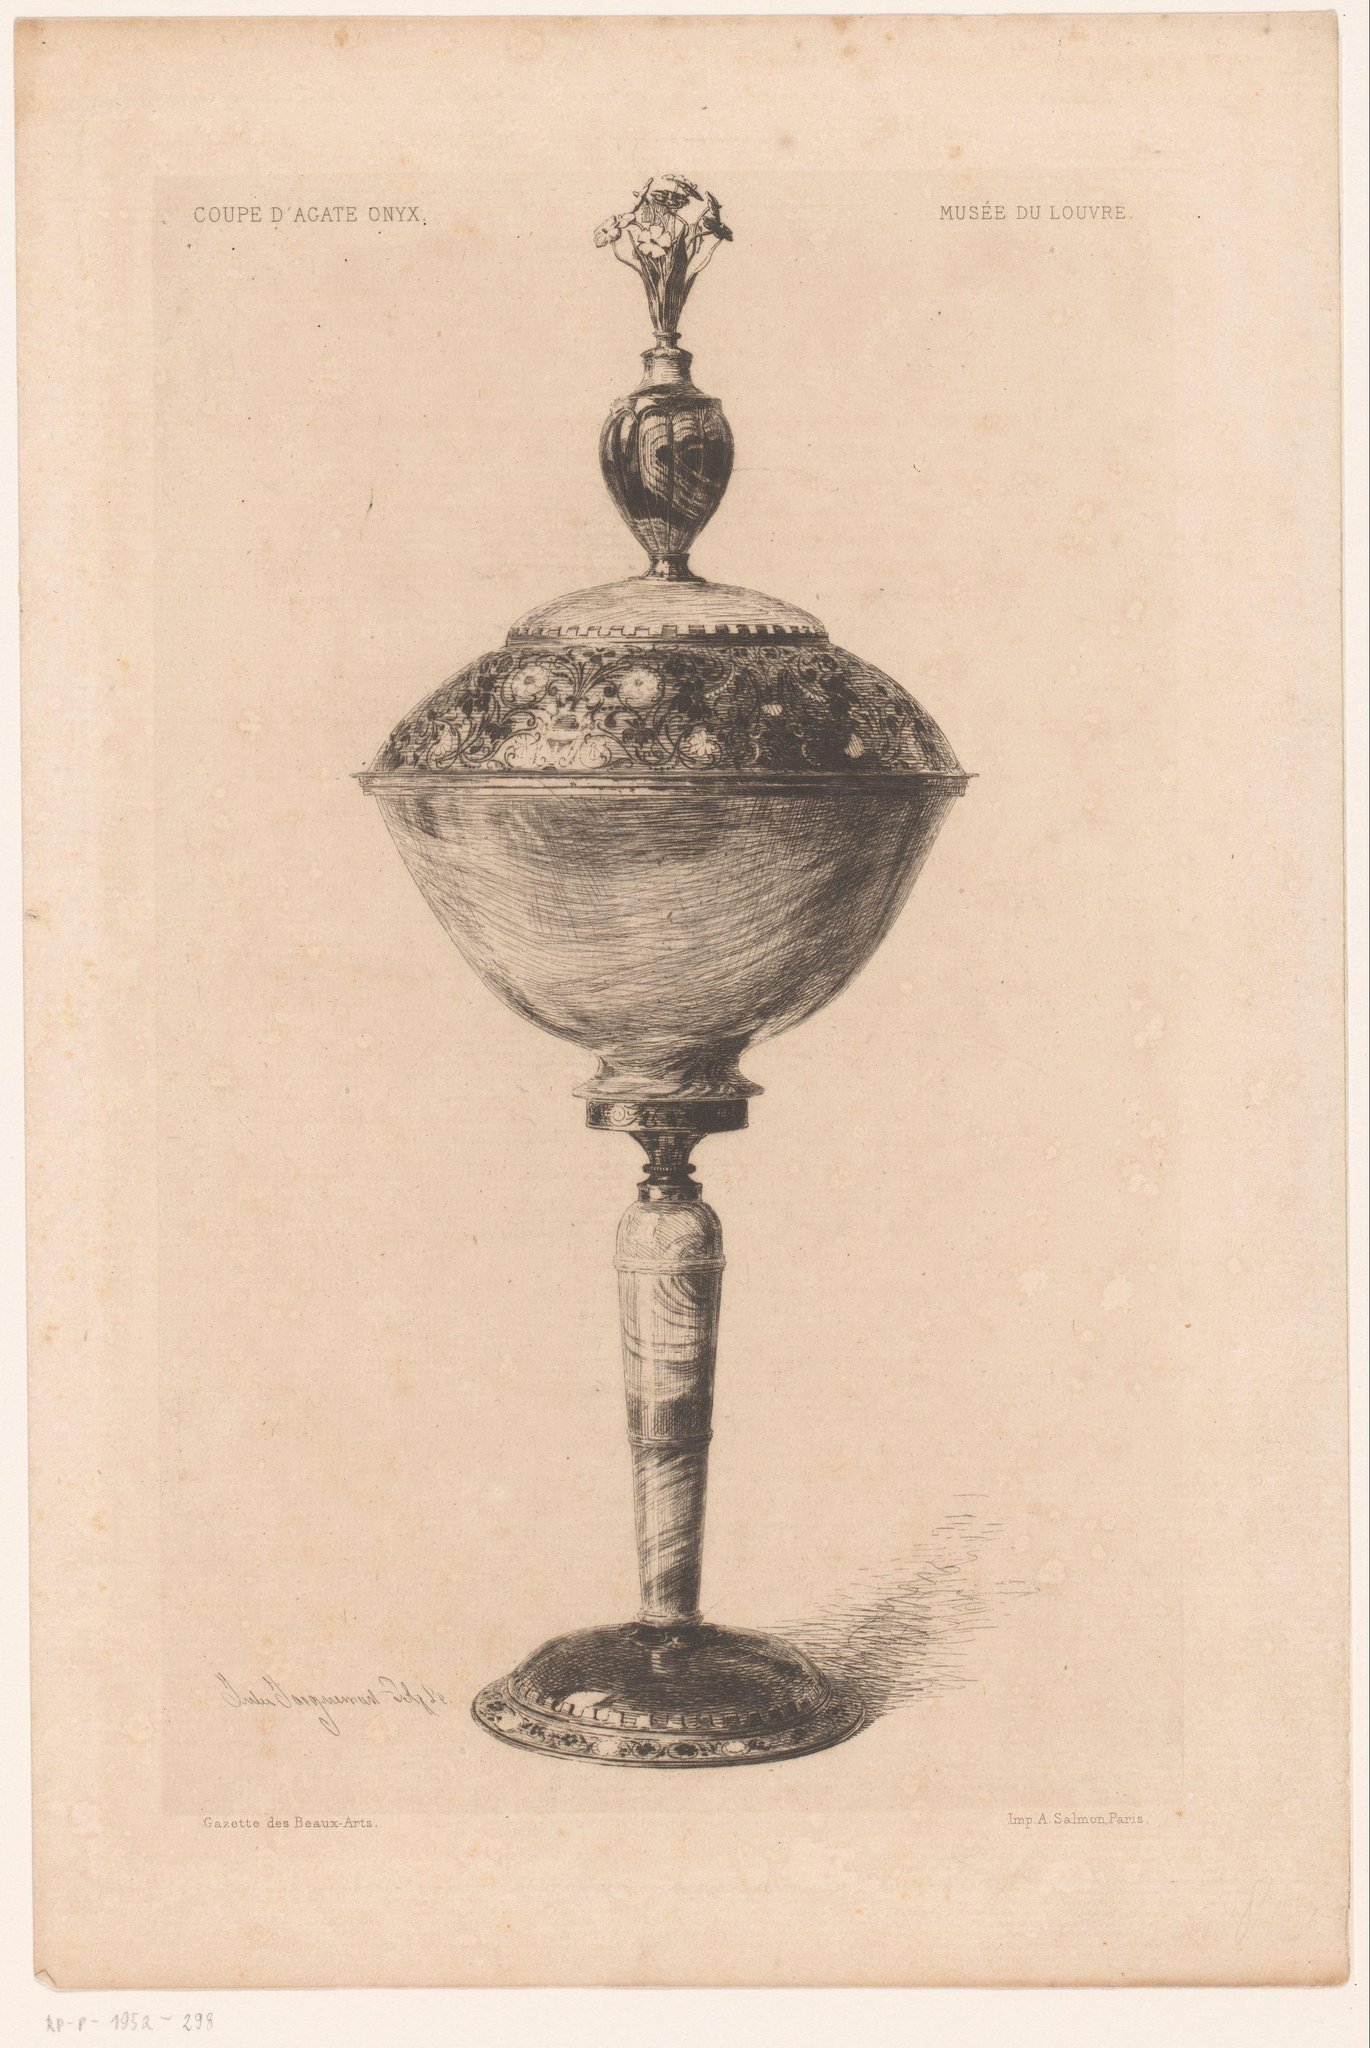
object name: print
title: Coupe d'agate onyx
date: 1865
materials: paper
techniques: drypoint, etching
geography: france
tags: chalice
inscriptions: collector's mark: Lugt 2228